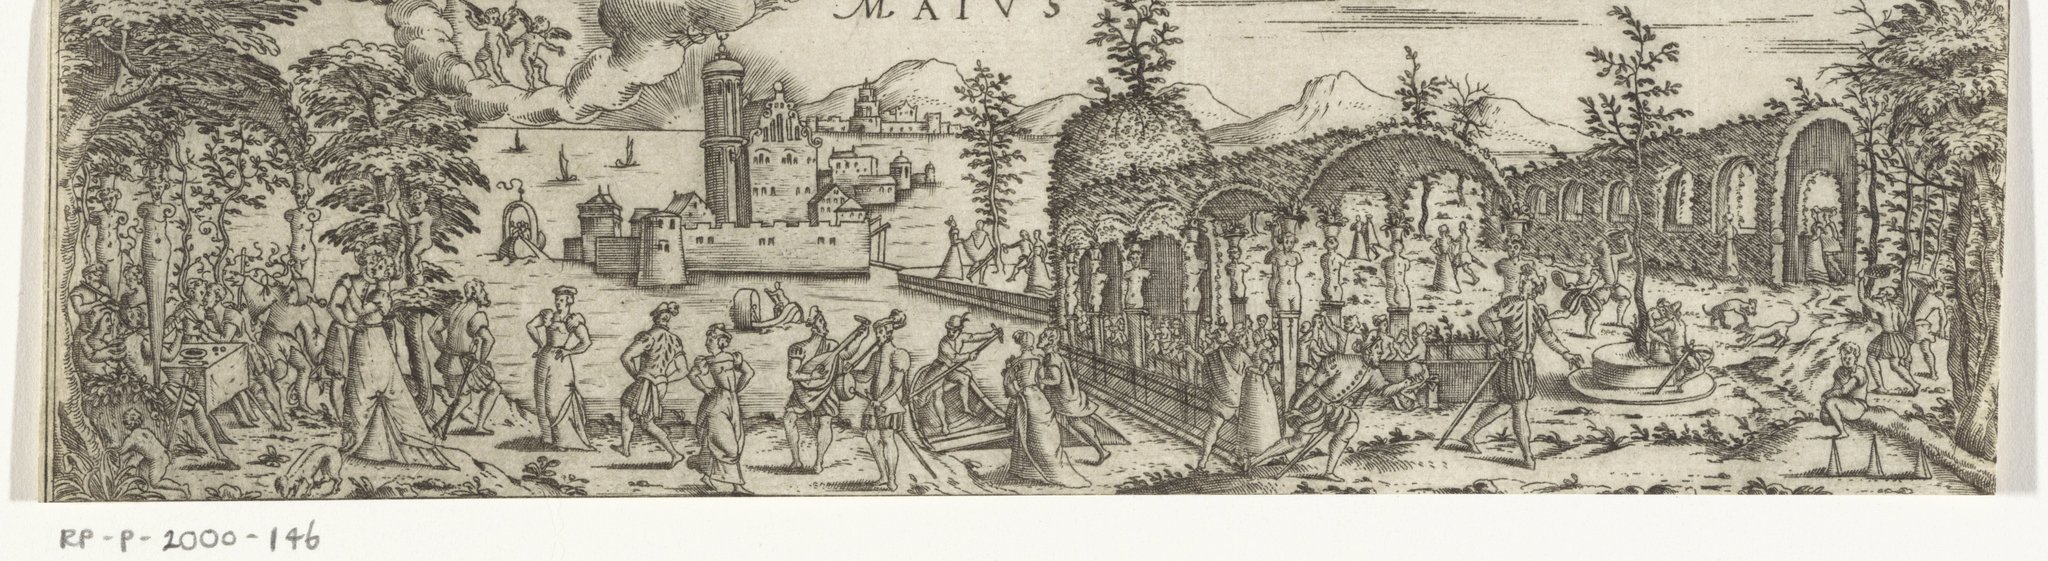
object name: print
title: Maius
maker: Anonymous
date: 1554-1641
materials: paper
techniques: etching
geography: netherlands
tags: may and its 'labours' (+ with zodiacal signs)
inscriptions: collector's mark: Lugt 2228, collector's mark: Lugt 2760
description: Bezigheden in de maand mei. Vooraan een dansend en musicerend gezelschap. Rechts een banket onder een pergola. In de verte een kasteel. Linksboven in de lucht het dierenriemteken Stier.